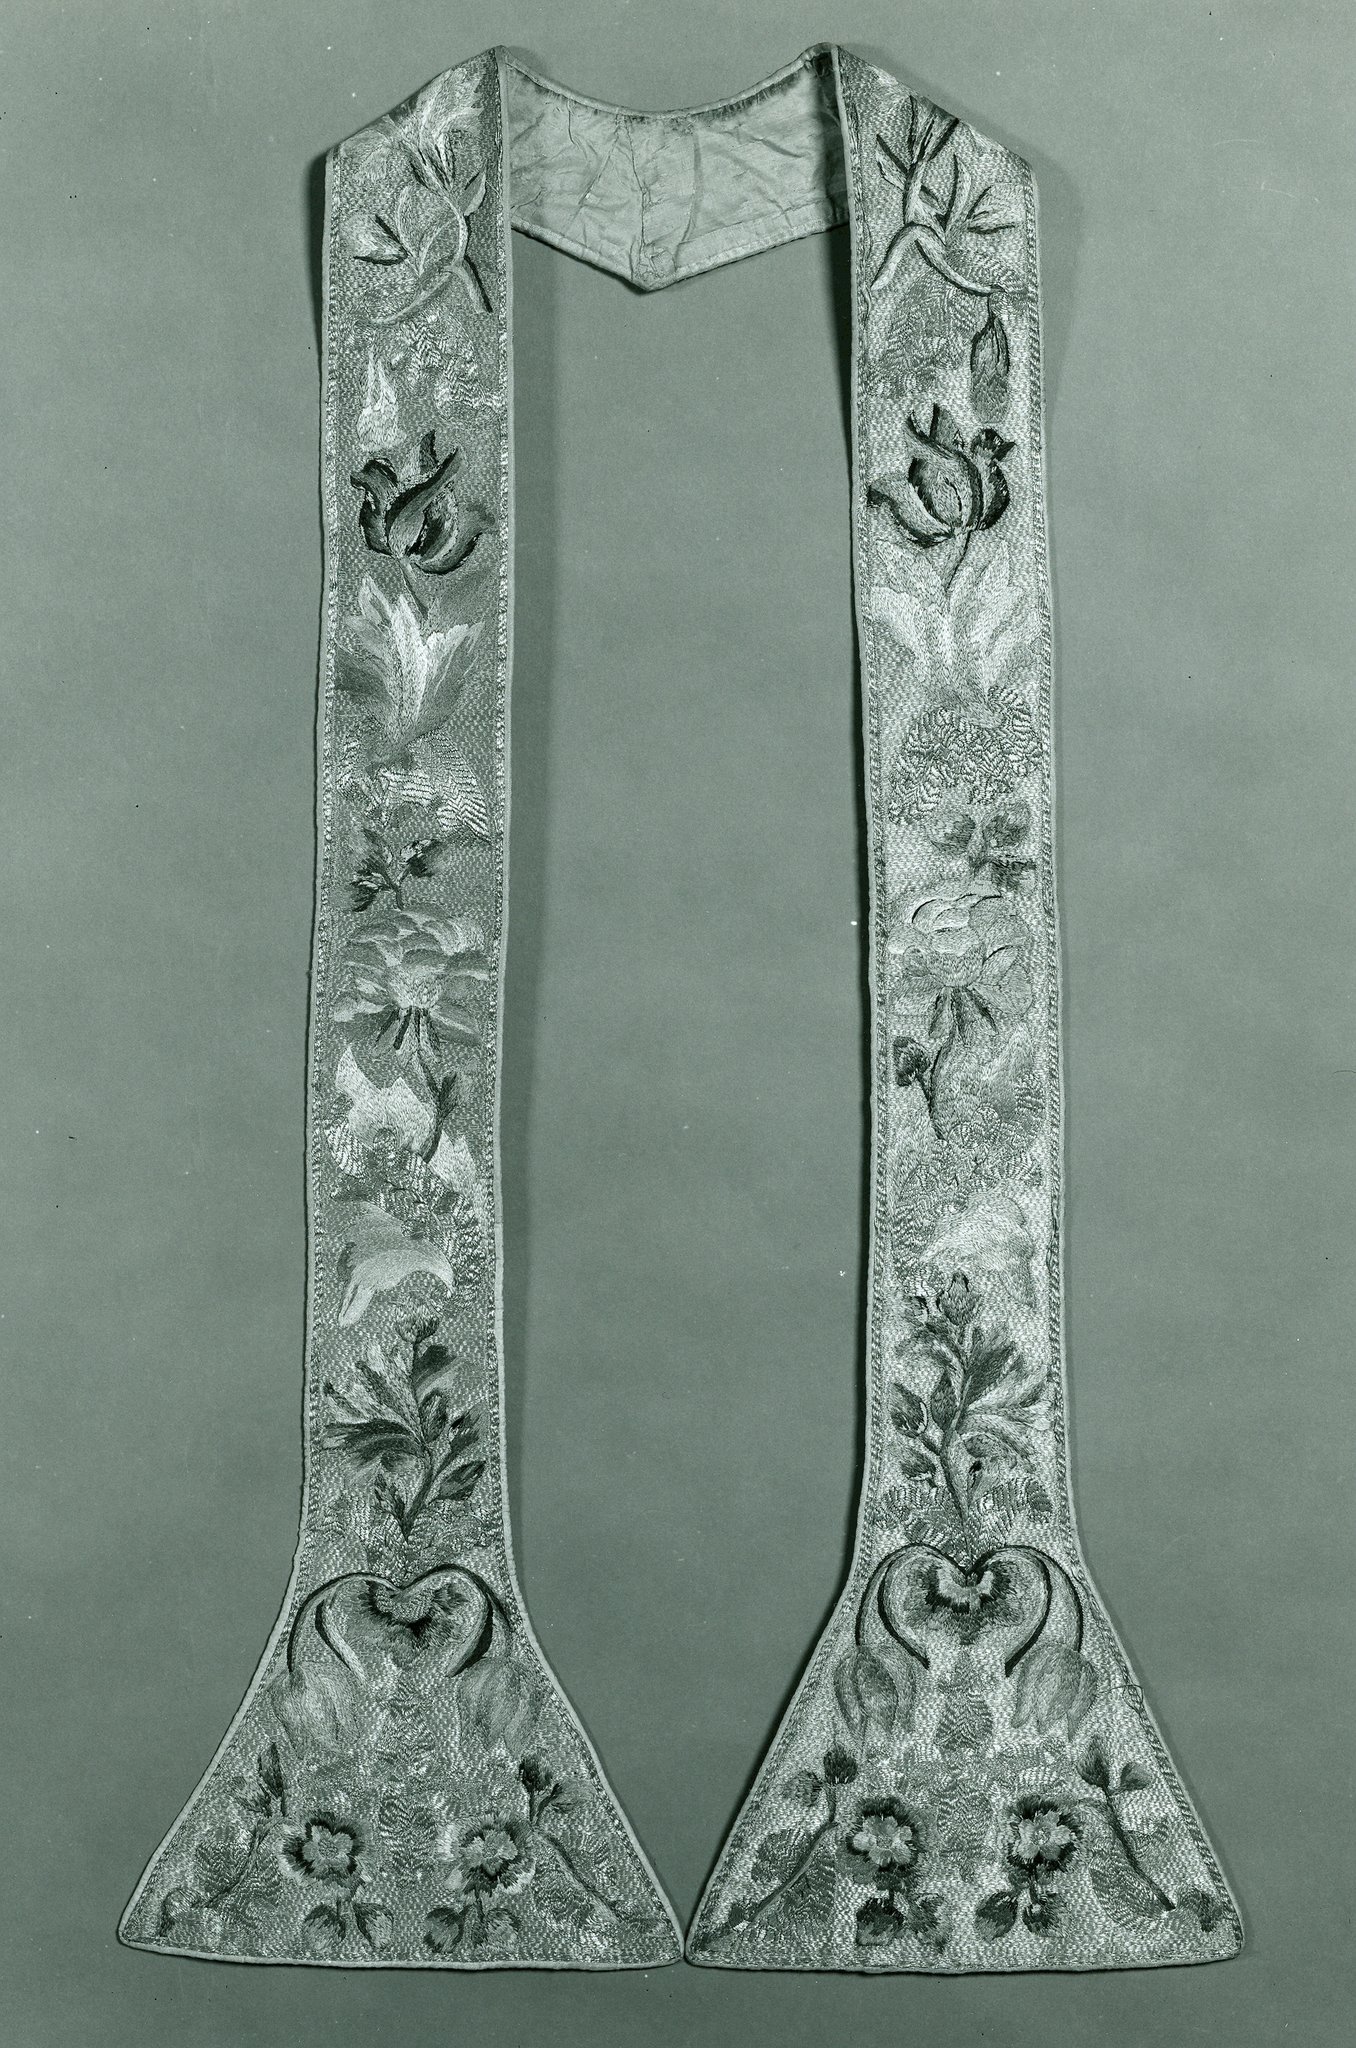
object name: stole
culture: italian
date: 1601-1800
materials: linen, metal, silk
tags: flowers